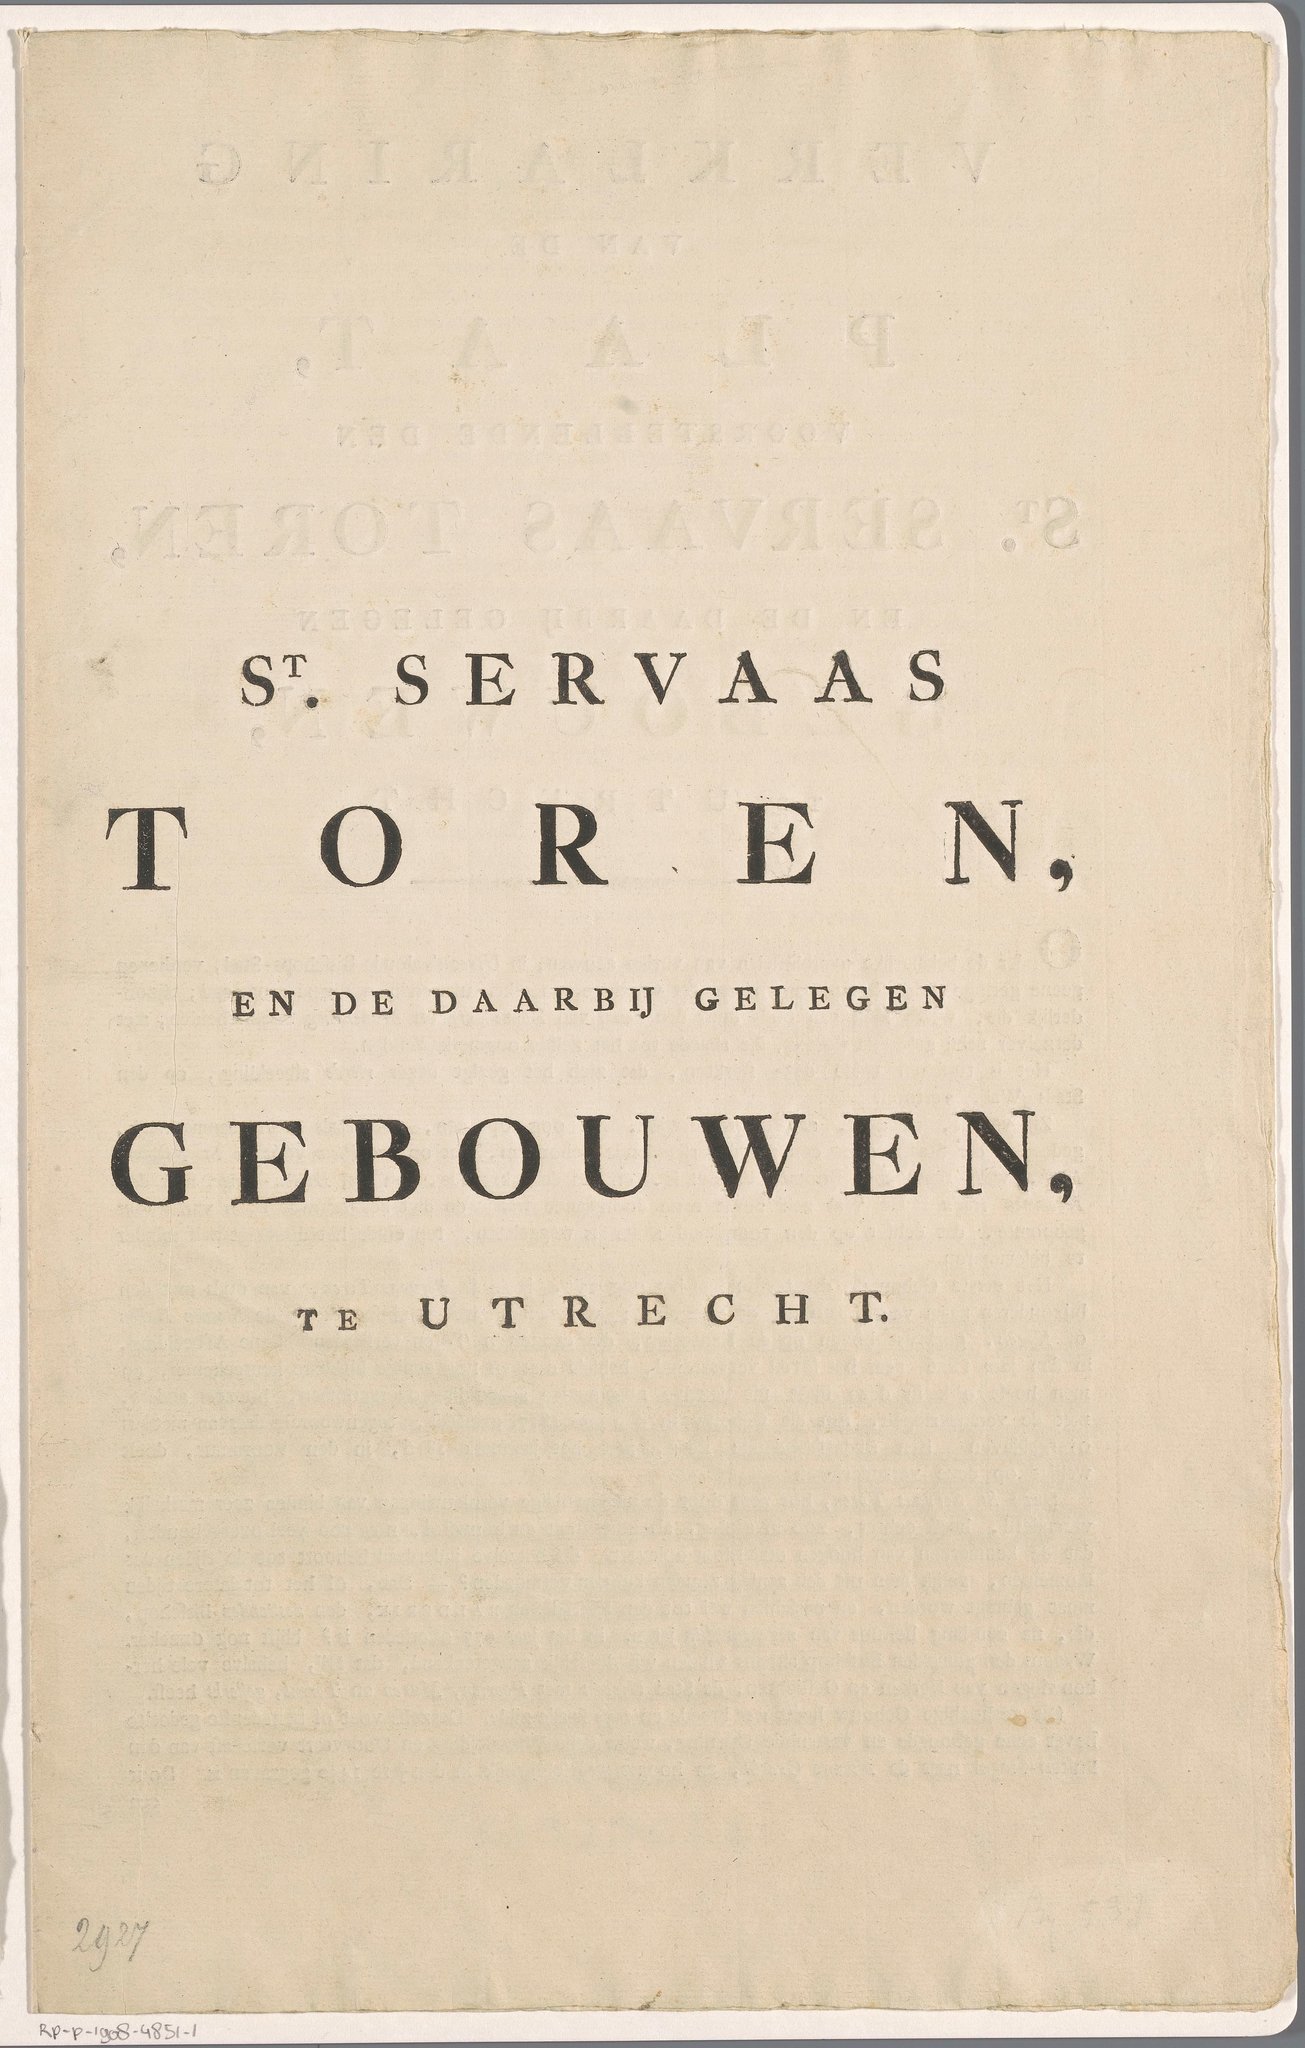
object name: print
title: Verklaring van de plaat met de St. Servaastoren en bijgelegen gebouwen in Utrecht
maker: a. judels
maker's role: publisher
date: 1789-1843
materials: paper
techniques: letterpress printing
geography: amsterdam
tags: utrecht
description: Los tekstblad met beschrijving behorende tot prent RP-P-1908-4851.